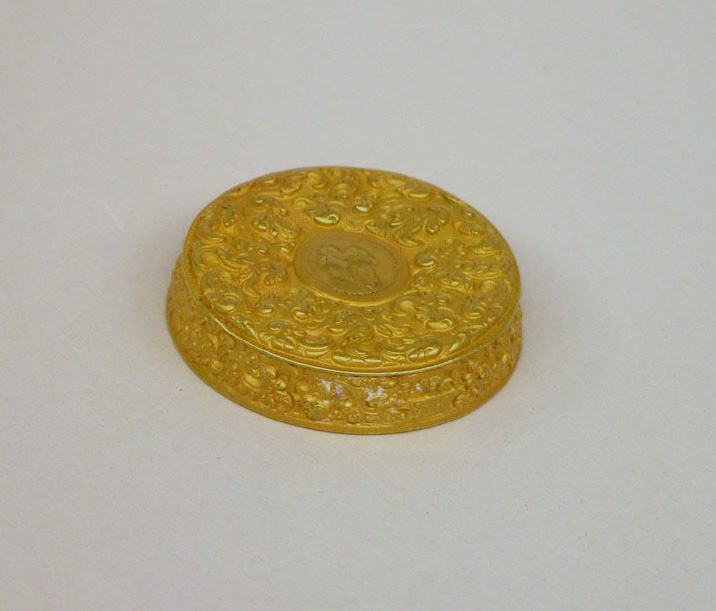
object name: ear plug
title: Subang Ear Plug with Central Stylized Aksara Motif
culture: indonesian, javanese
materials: gold